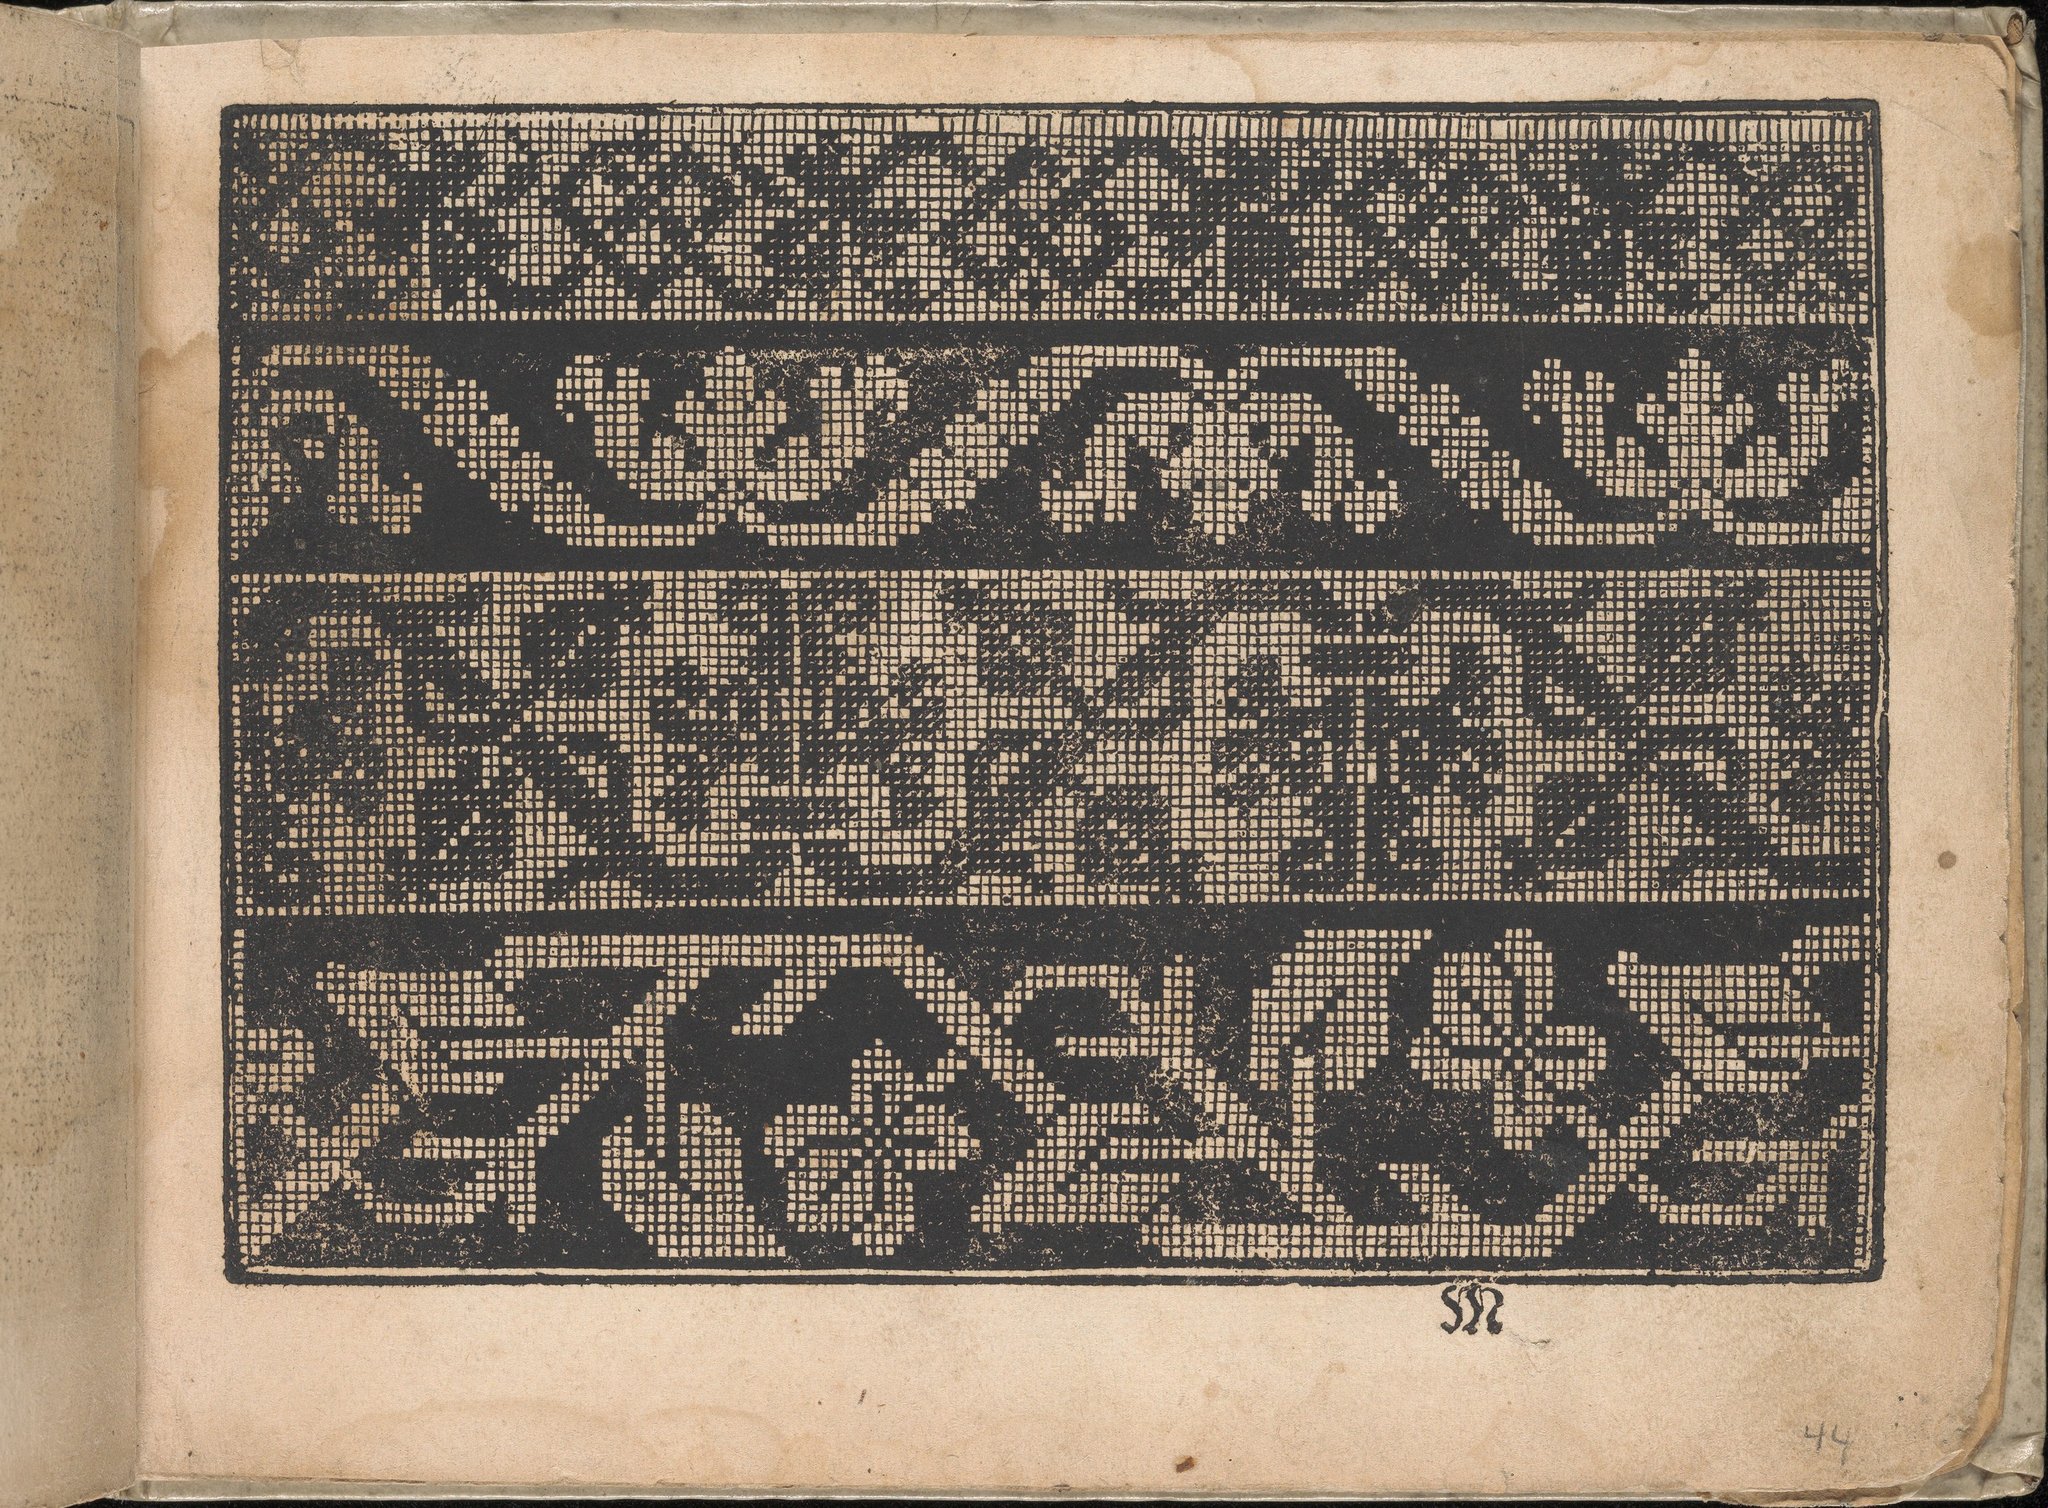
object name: book print ornament architecture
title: Neu künstlich Modelbuch (page 44r)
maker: bernhard jobin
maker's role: publisher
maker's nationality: swiss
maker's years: 1535-1597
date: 1598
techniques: woodcut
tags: flowers